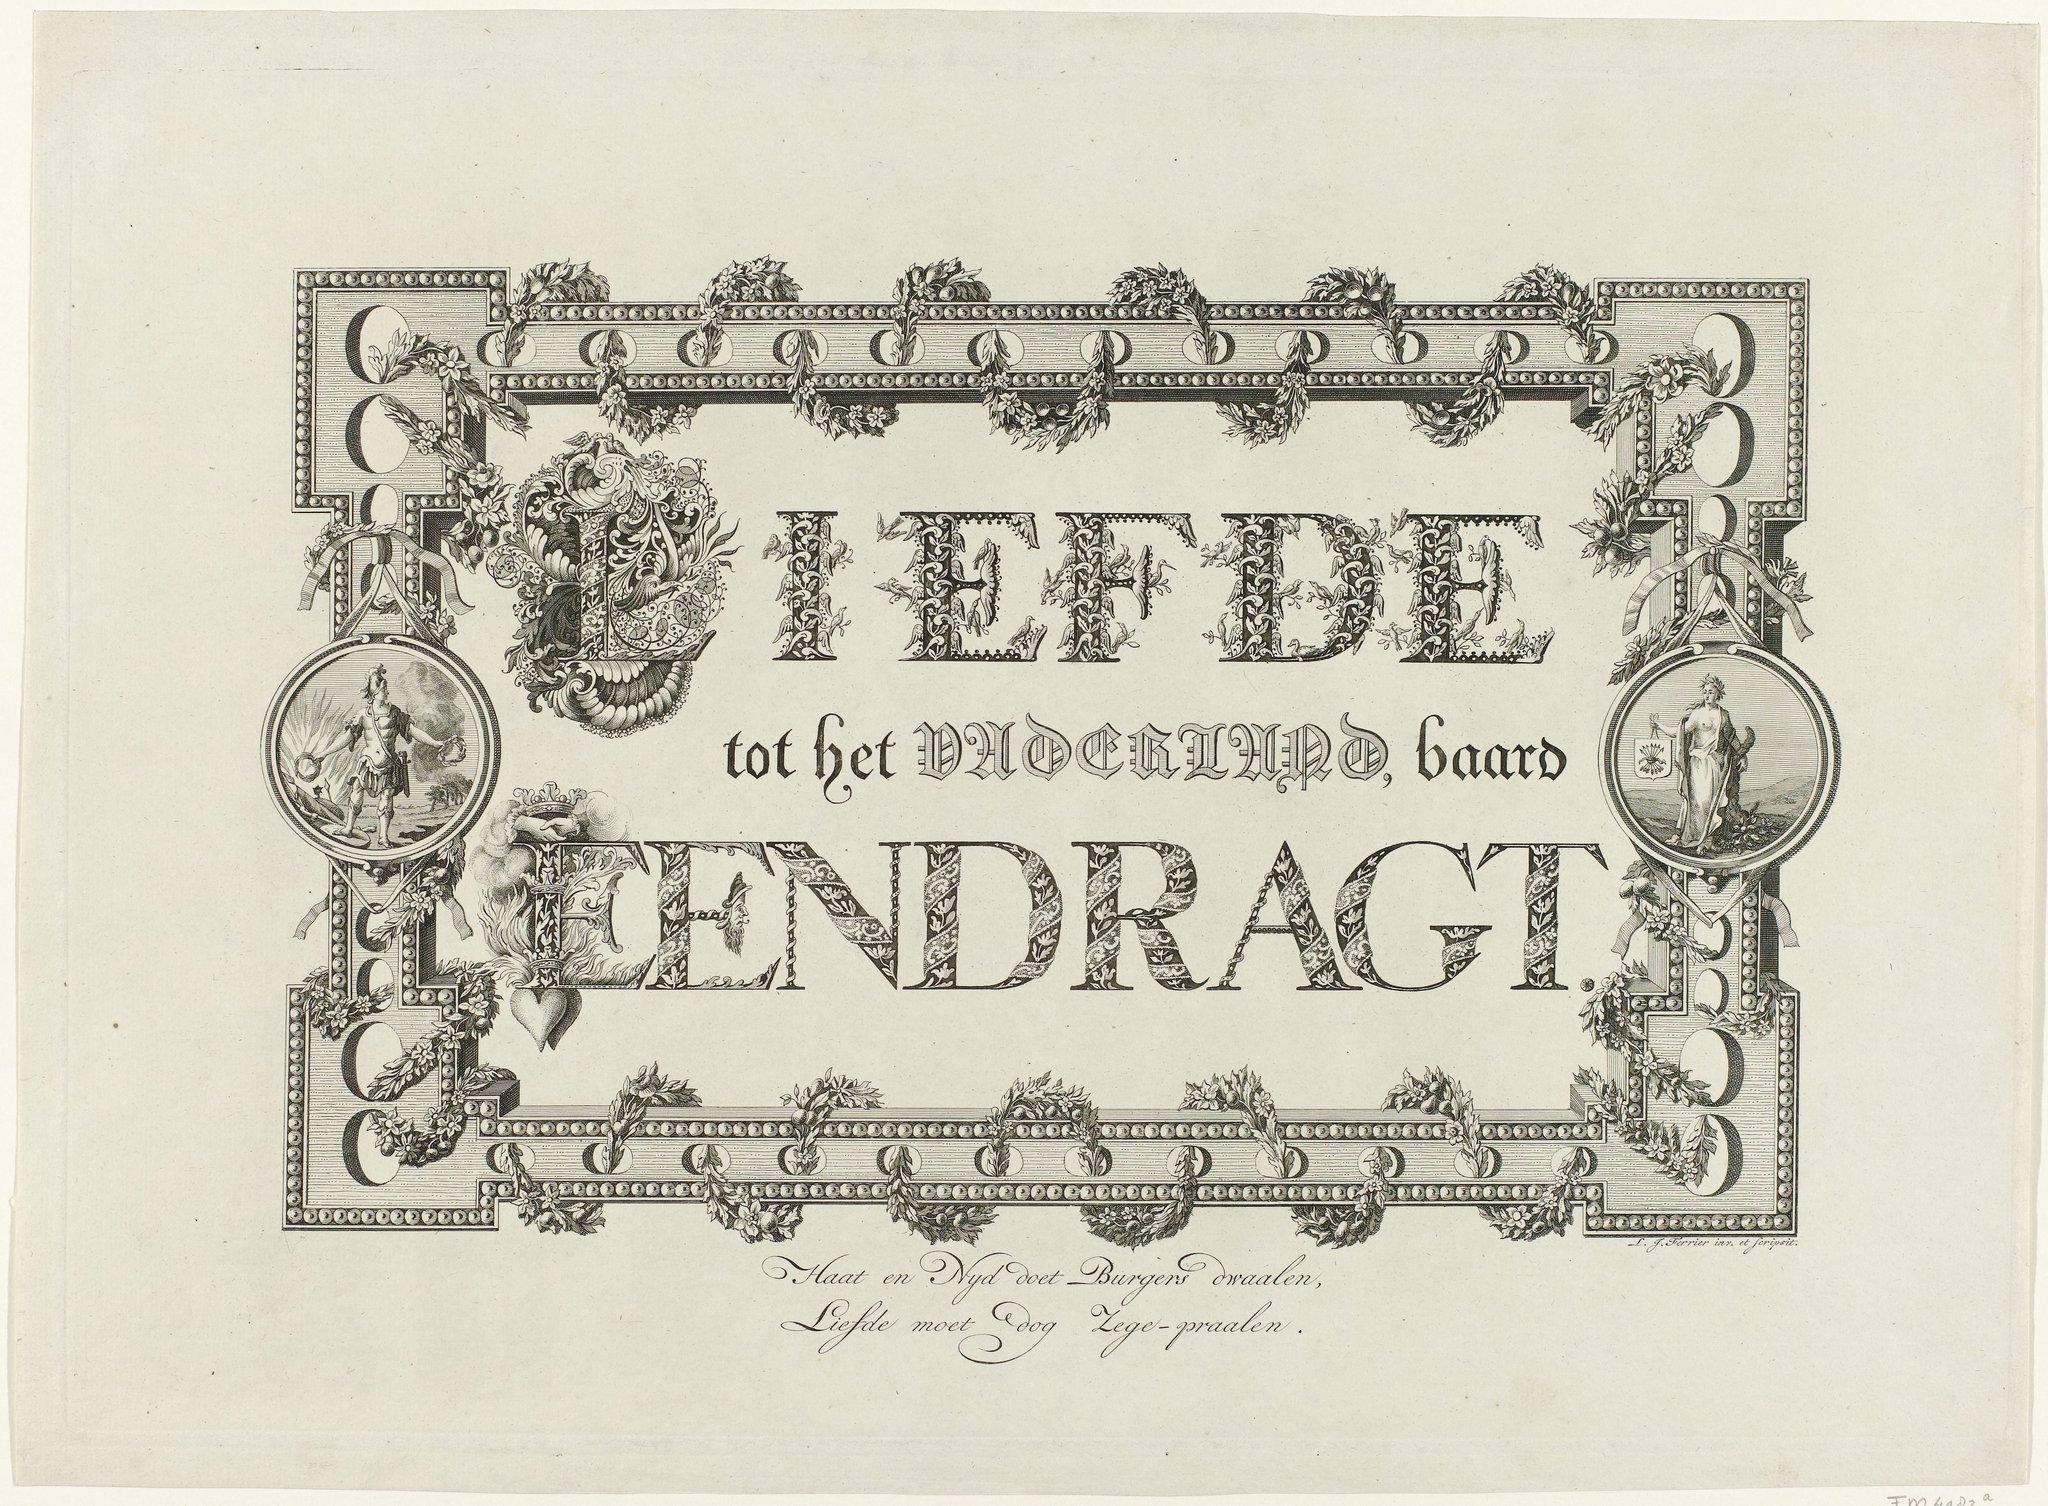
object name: calligraphy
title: Liefde tot het Vaderland, baard Eendragt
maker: leonard jozef ferrier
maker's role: silversmith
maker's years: 1726-1801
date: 1787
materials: paper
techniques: engraving, etching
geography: northern netherlands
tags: calligraphy, netherlands, patriots (1780-1795)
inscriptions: collector's mark: Lugt 2228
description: Kalligrafische allegorie op de eendracht van het land, 1787. Met twee allegorische medaillons op de eendracht. Onderaan een tweeregelig vers.